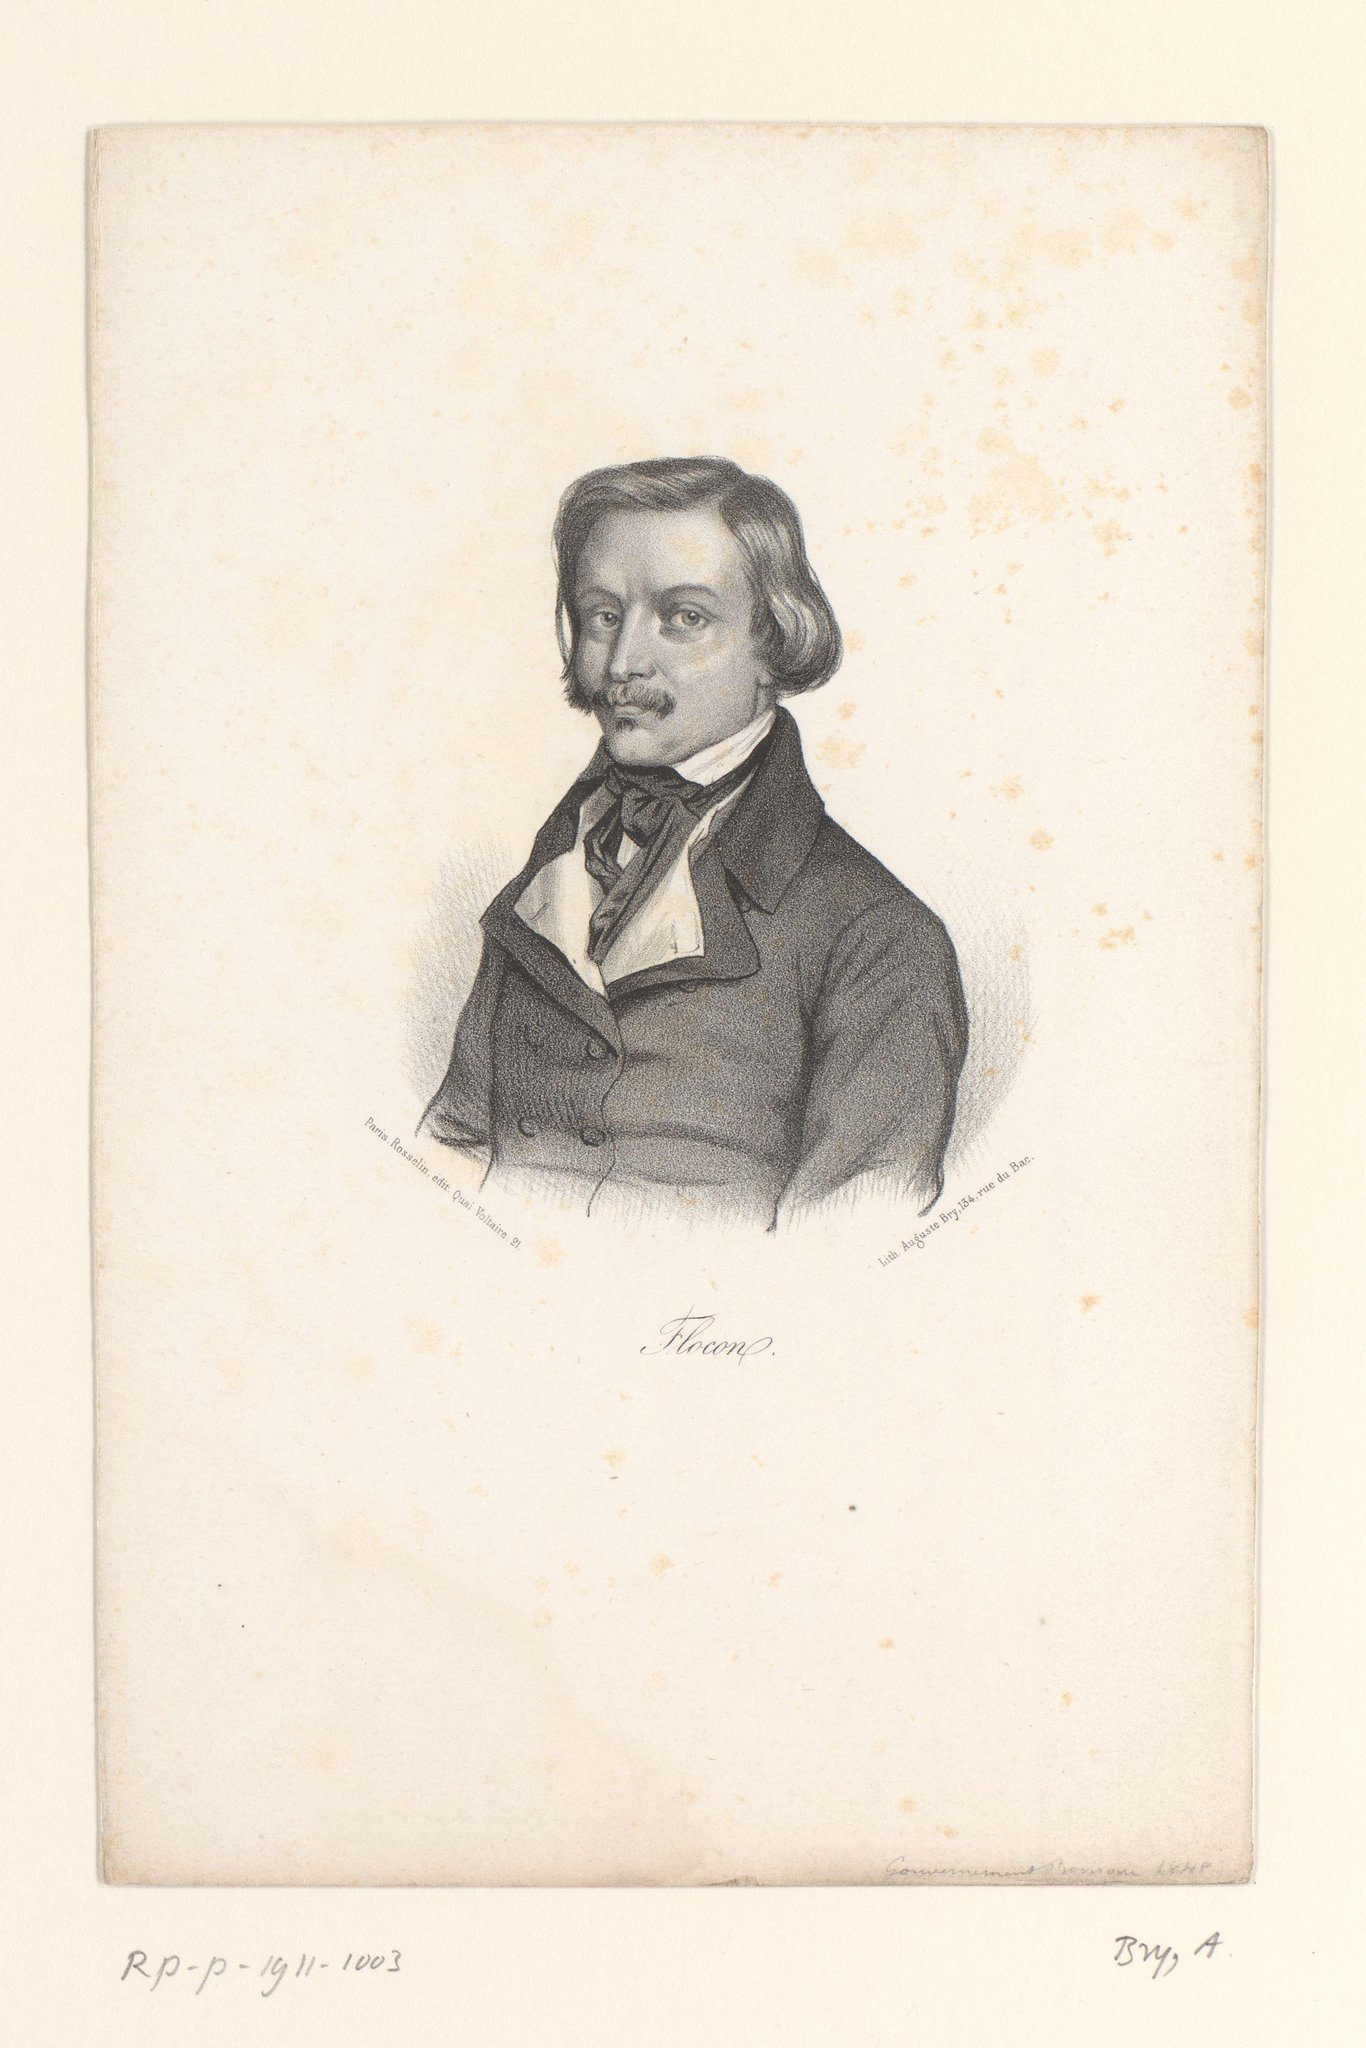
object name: print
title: Flocon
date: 1848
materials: paper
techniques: lithograph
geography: paris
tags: paris, politician, historical persons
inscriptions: collector's mark: Lugt 2228a